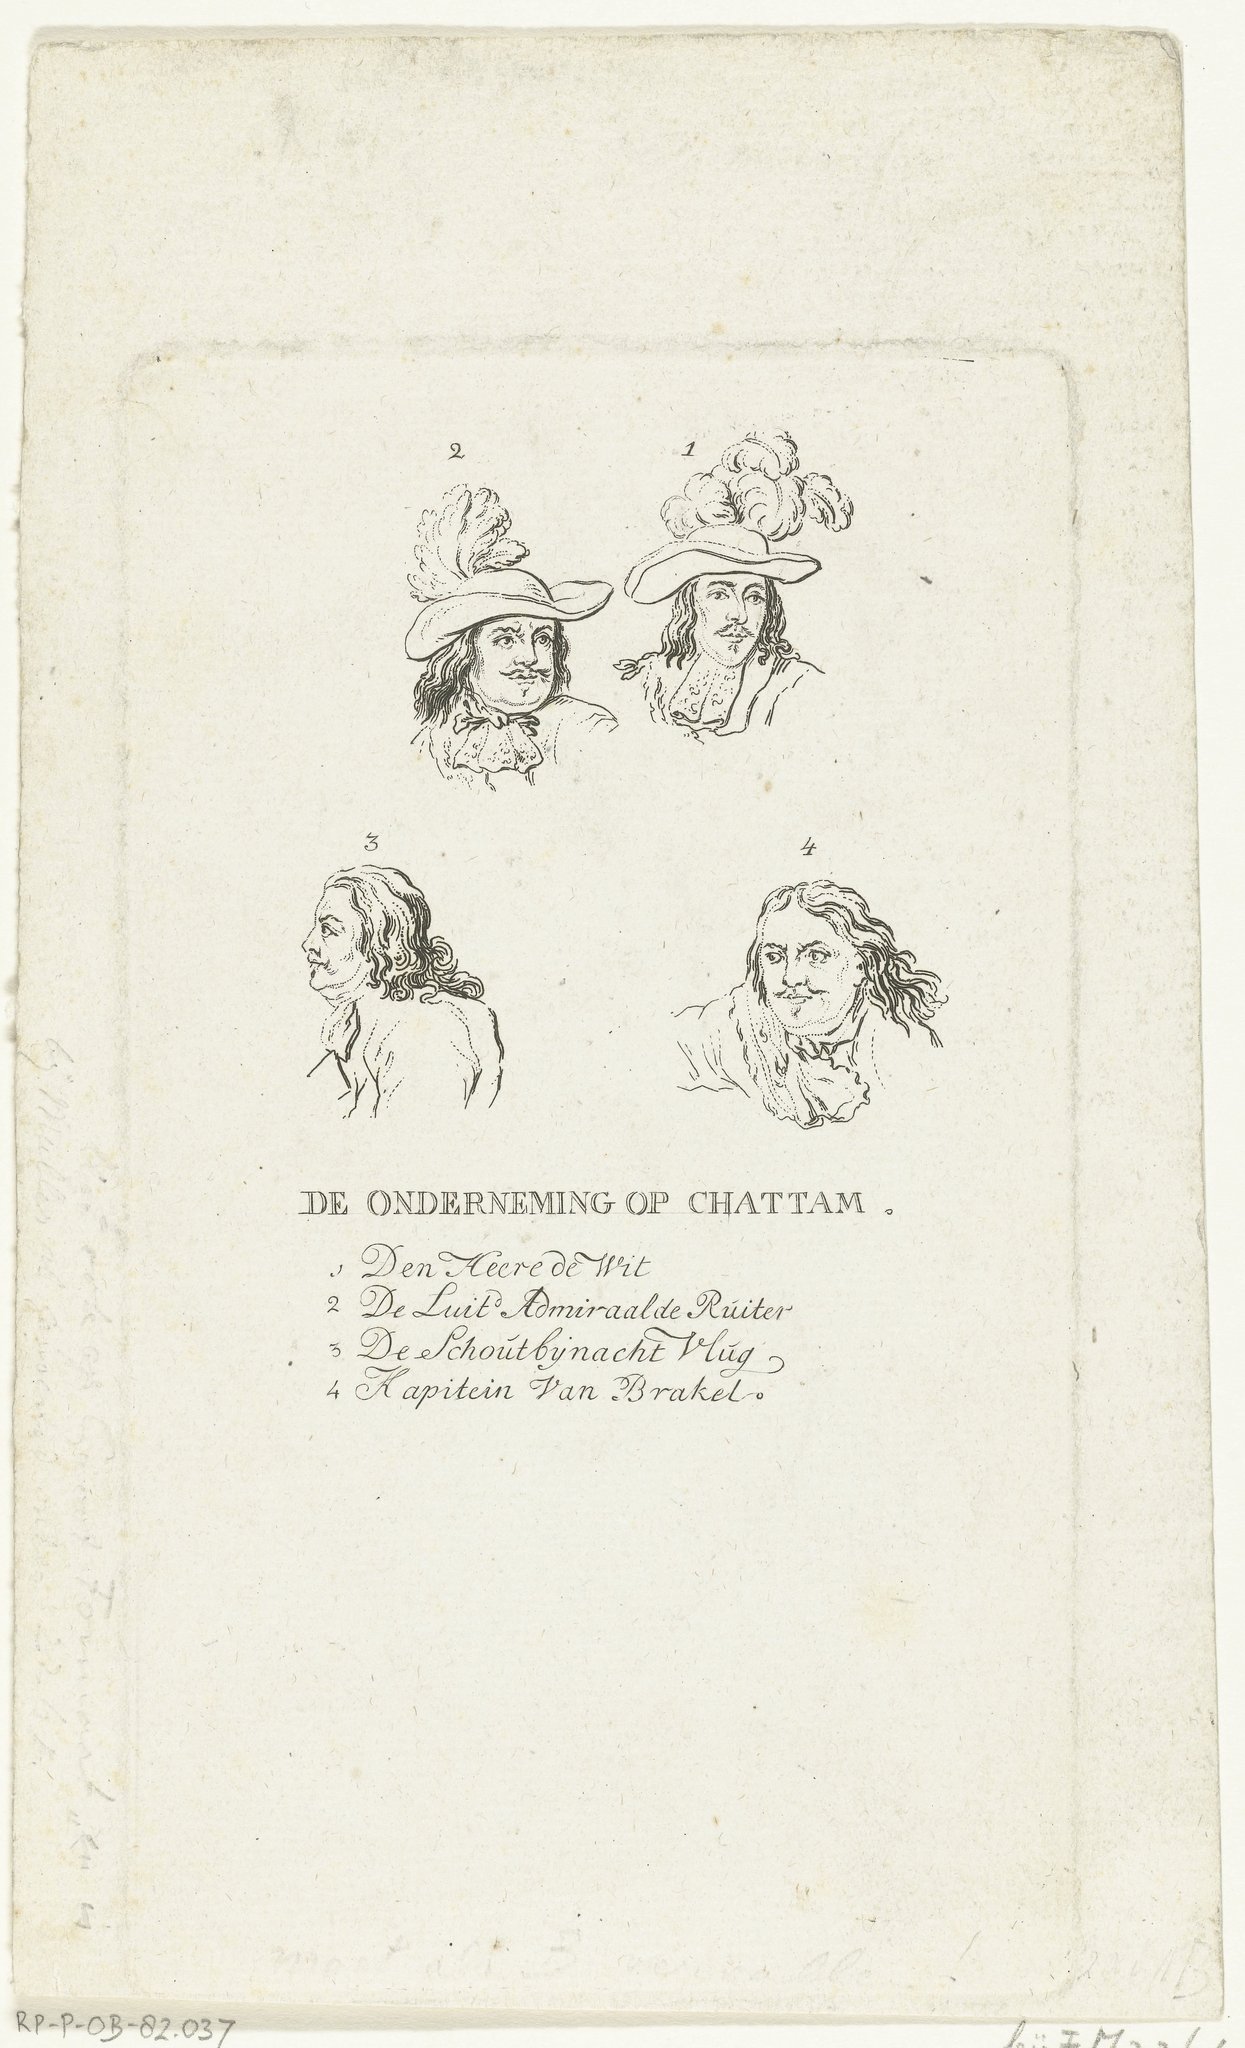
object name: history print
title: De Tocht naar Chatham en de verovering van de Royal Charles, 1667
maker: mathias de sallieth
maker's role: print maker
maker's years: 1749-1791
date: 1782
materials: paper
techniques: etching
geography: northern netherlands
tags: flushing, michiel adriaenszoon de ruyter, dordrecht, the hague, cornelis de witt, raid on the medway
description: De hoofden van de vier hoofdpersonen op de voorstelling van de gevechten te Chatham en de verovering van het Engelse vlaggeschip de Royal Charles op 22 juni 1667. De hoofden genummerd 1: Cornelis de Witt, 2: Michiel Adriaenszoon de Ruyter, 3: schout-bij-nacht David Vlugh, 4: kapitein Jan van Brakel. Deze sleutel behoort bij de grote voorstelling van het gevecht.